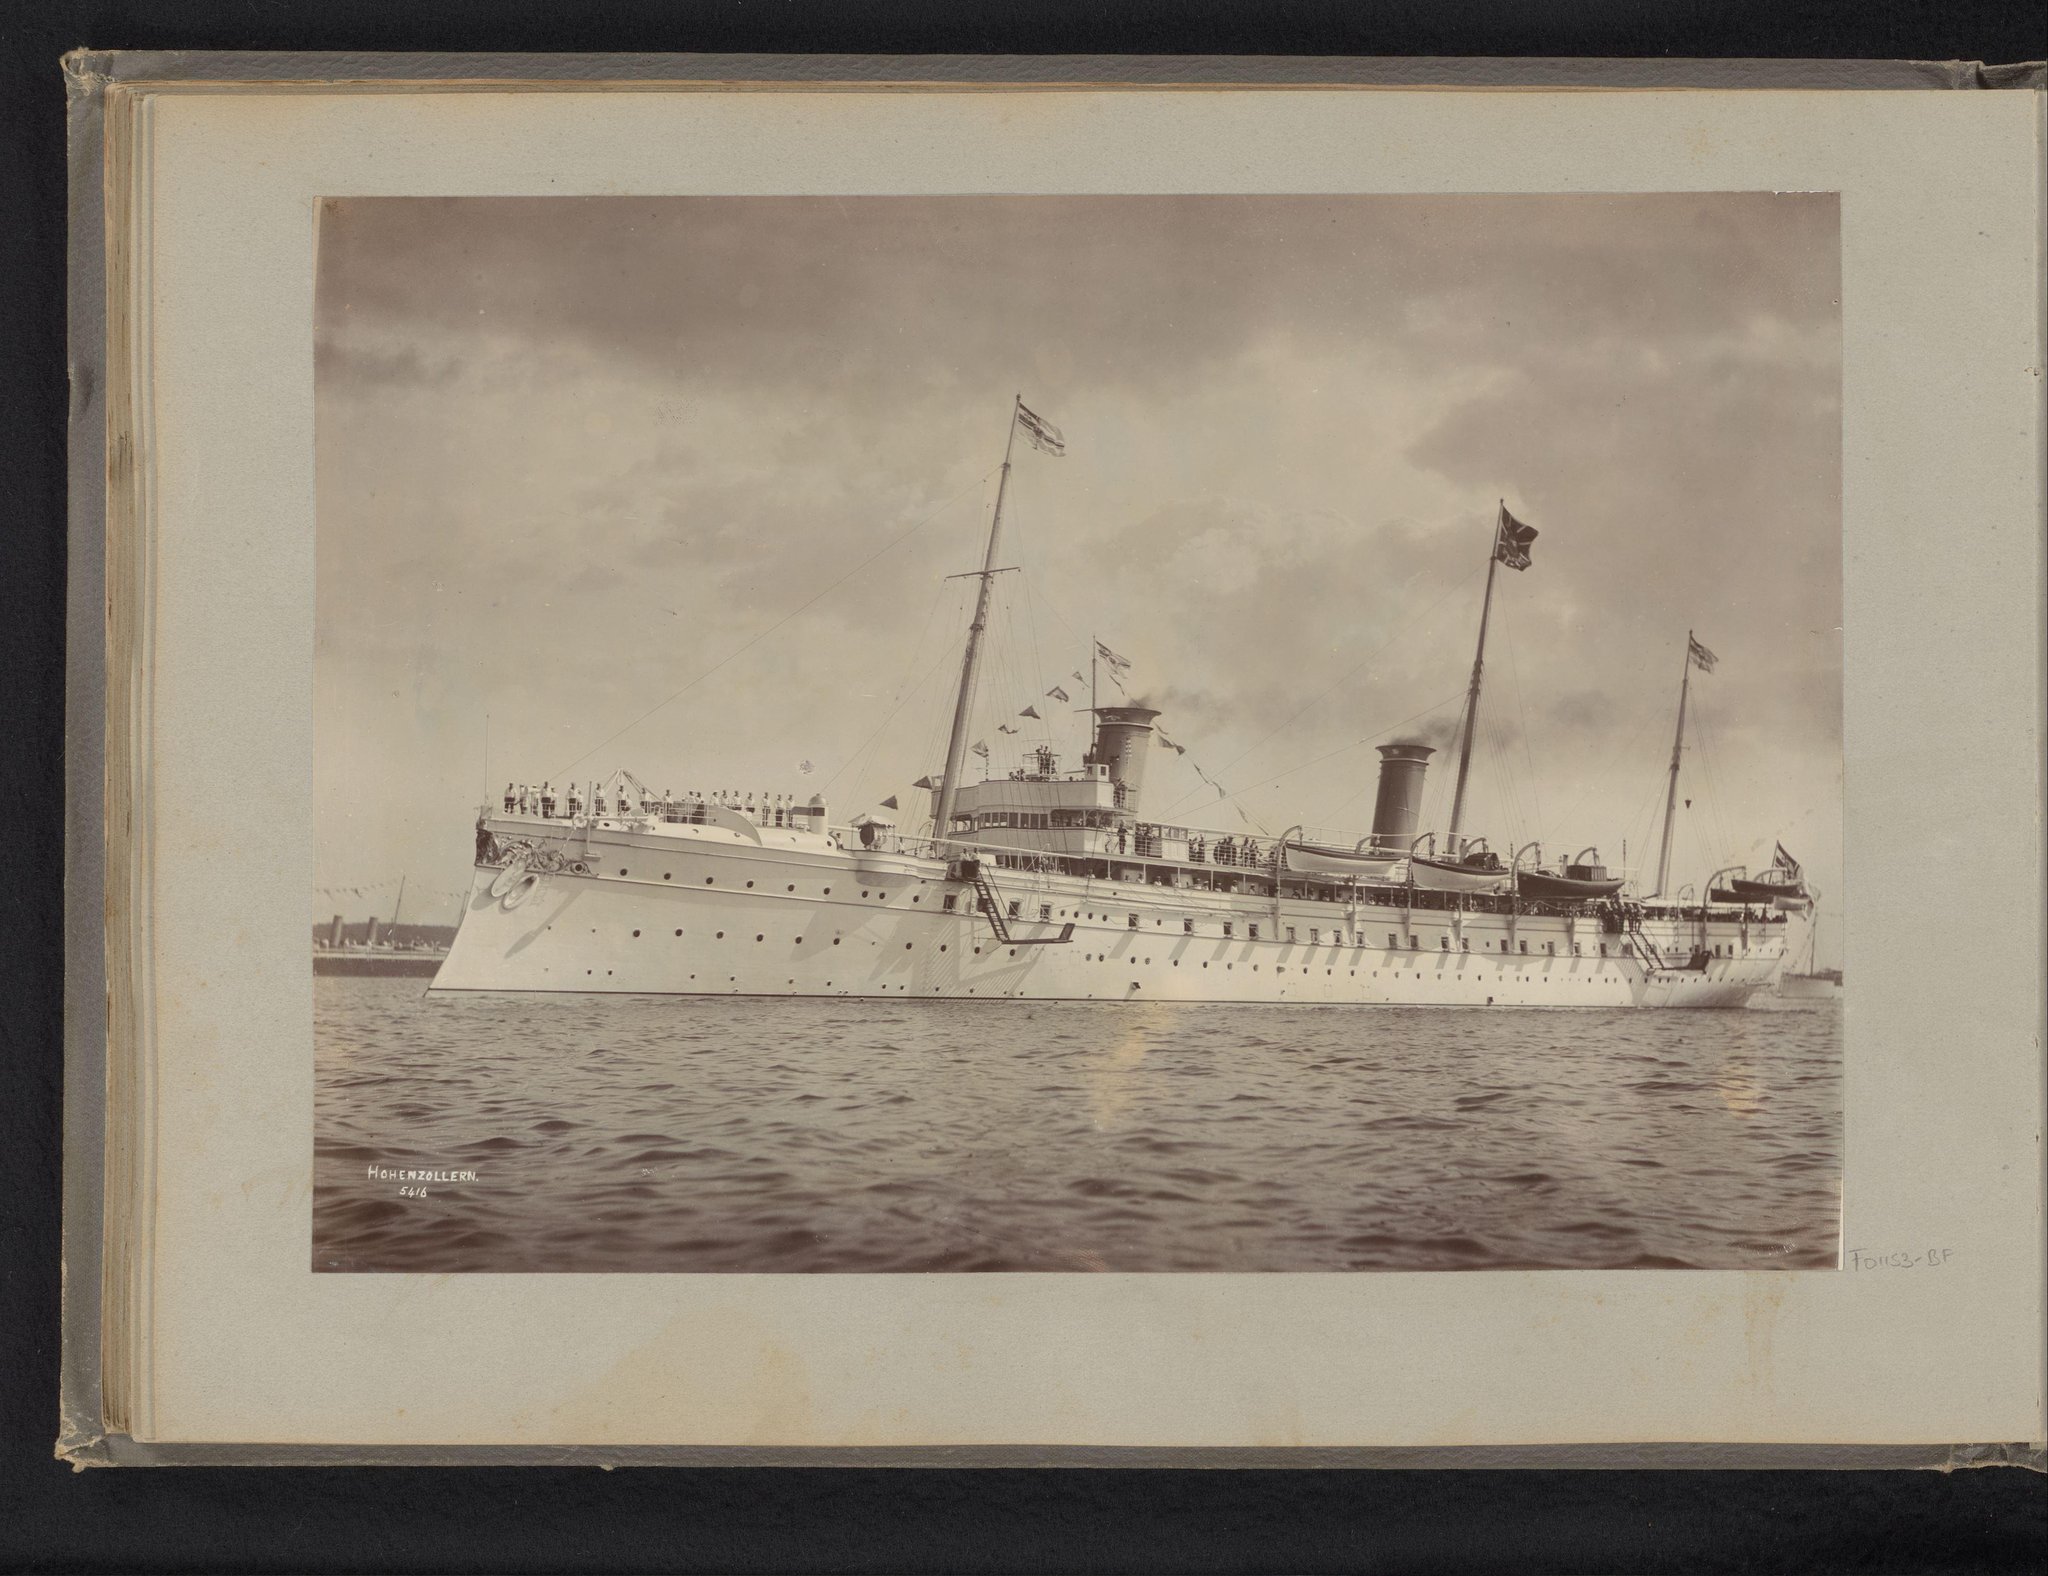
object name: photograph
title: SMY Hohenzollern II te water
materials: photographic support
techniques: gelatin silver print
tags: landscapes with waters, waterscapes, seascapes (in the temperate zone), steamship, motorship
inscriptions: inscription: ‘Hohenzollern/ 5416’, name: ‘Symonds & Co/ Copyright/ Portsmouth’